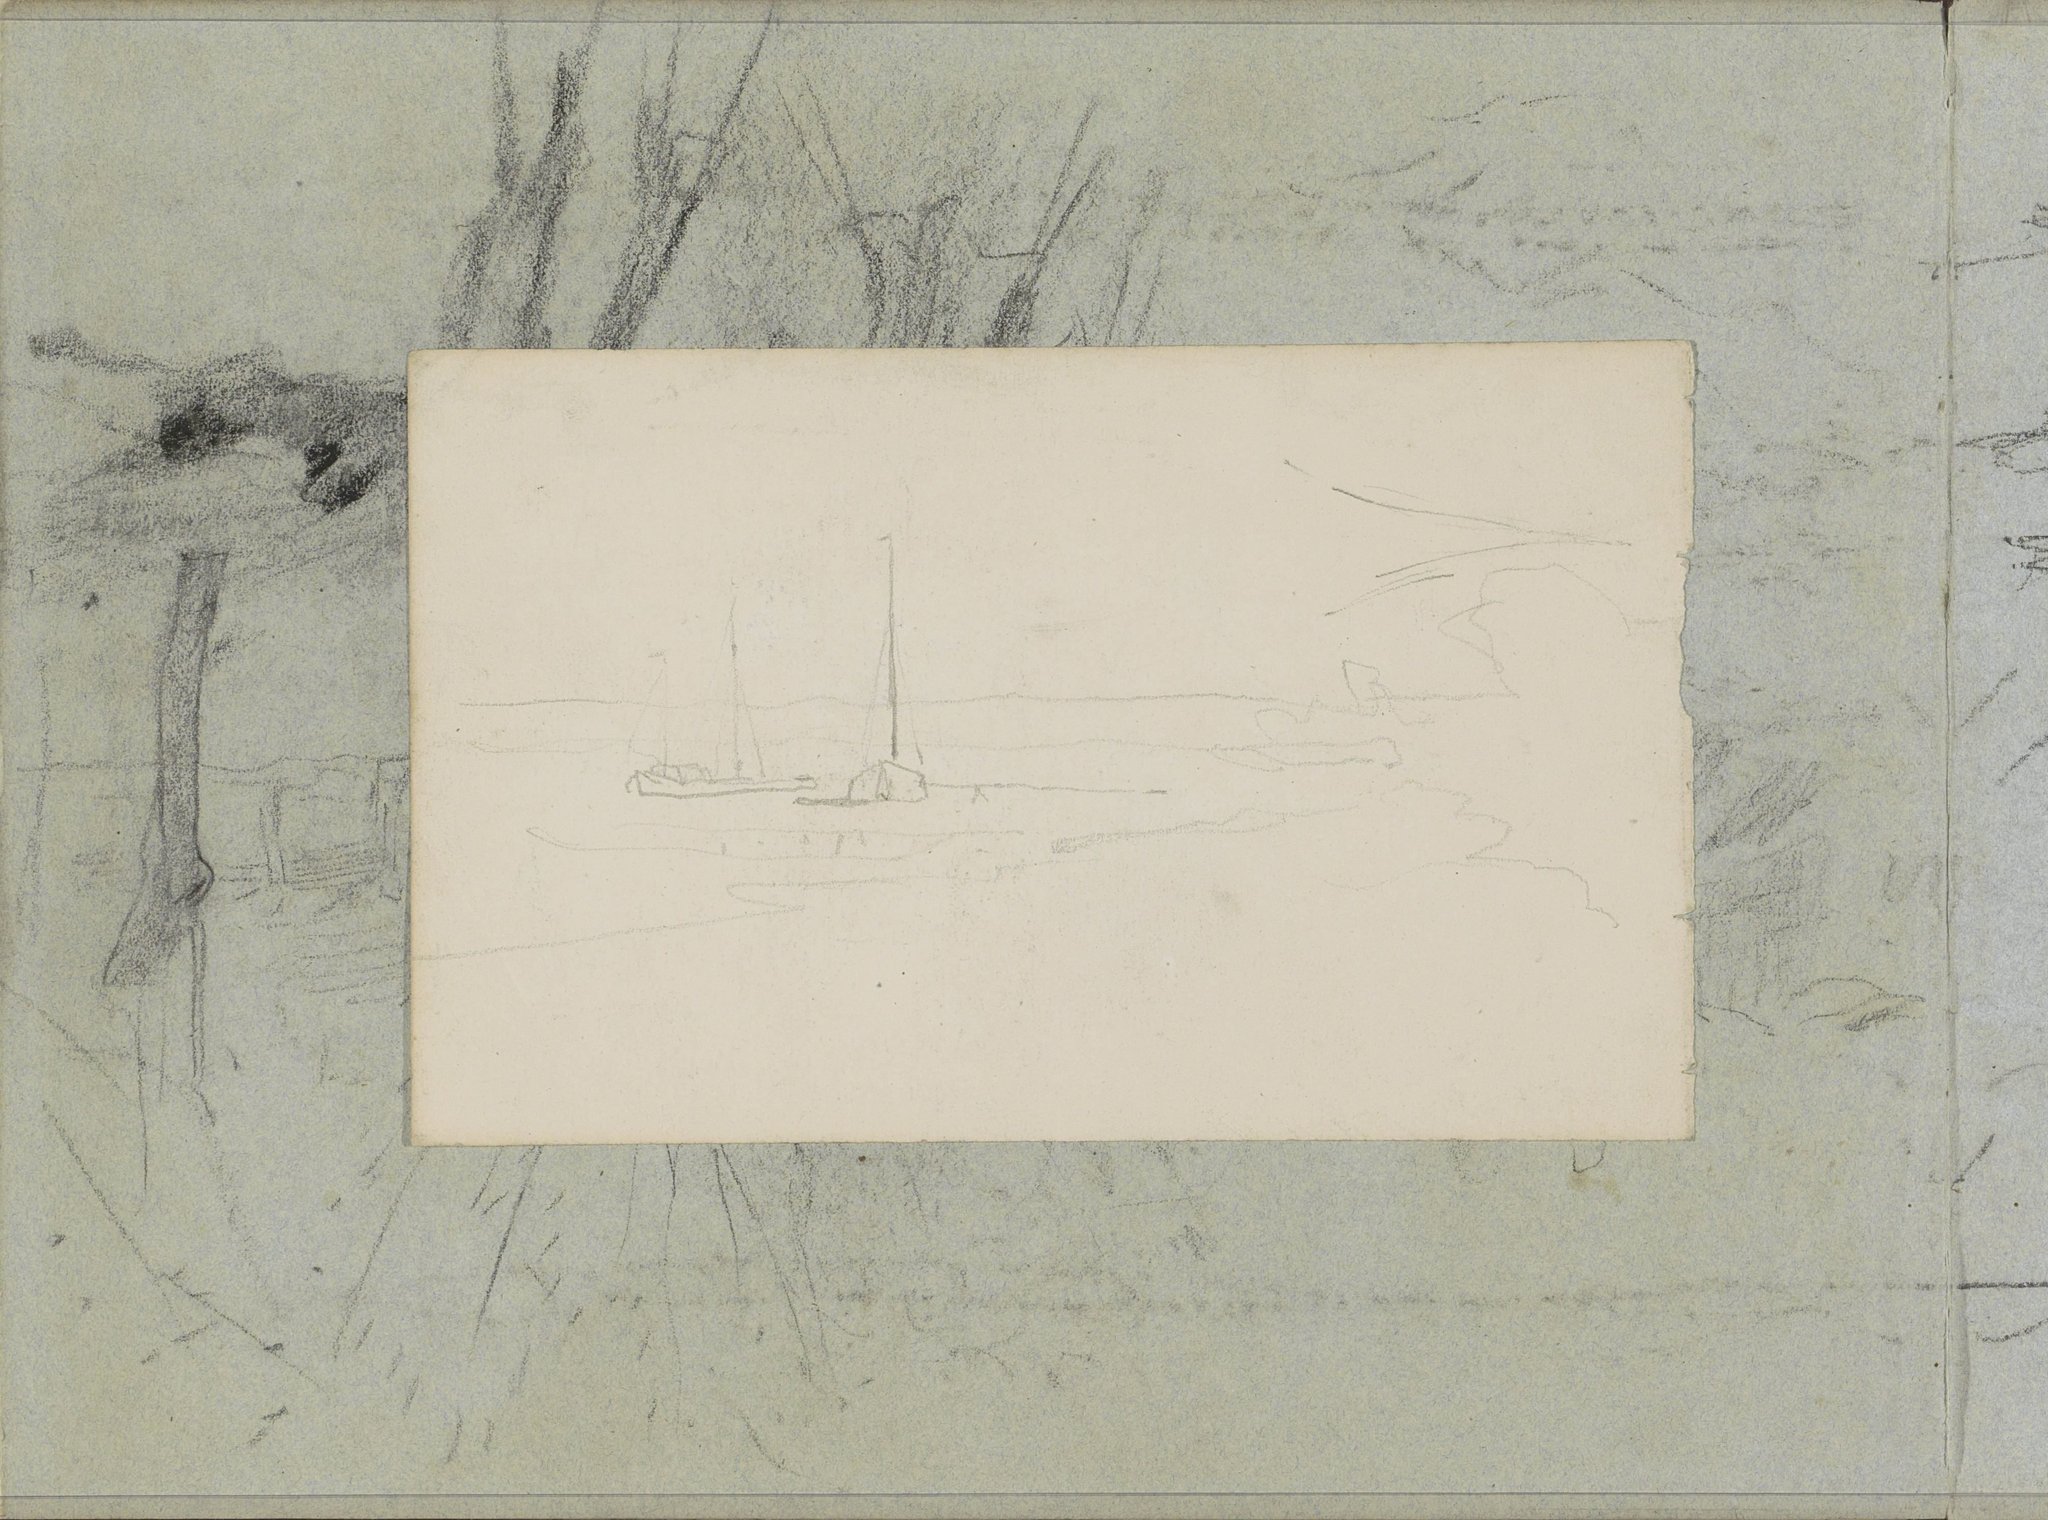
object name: sketchbook leaf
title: Zeilschepen op het water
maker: anton mauve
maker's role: draughtsman, painter, print maker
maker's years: 1838-1888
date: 1886-1888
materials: paper, pencil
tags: sailing-ship, sailing-boat, landscapes with waters, waterscapes, seascapes (in the temperate zone)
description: Verso-zijde van een los blad tussen pagina 27 en het achterste schutblad uit een schetsboek met 27 bladen.